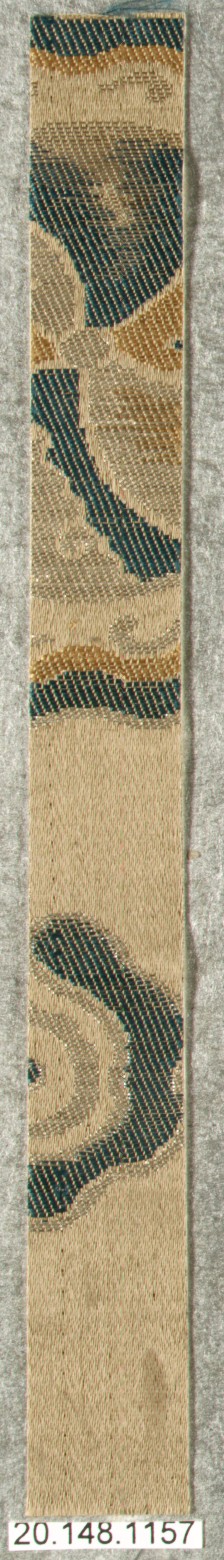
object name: piece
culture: japanese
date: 1801-1900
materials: silk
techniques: compound weave